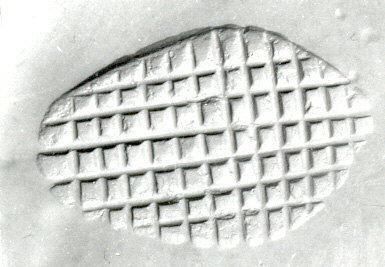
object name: stamp seal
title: Loop-handled conical (?) stamping device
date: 7000-5001 BCE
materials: mineral, stone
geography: northern syria (?)